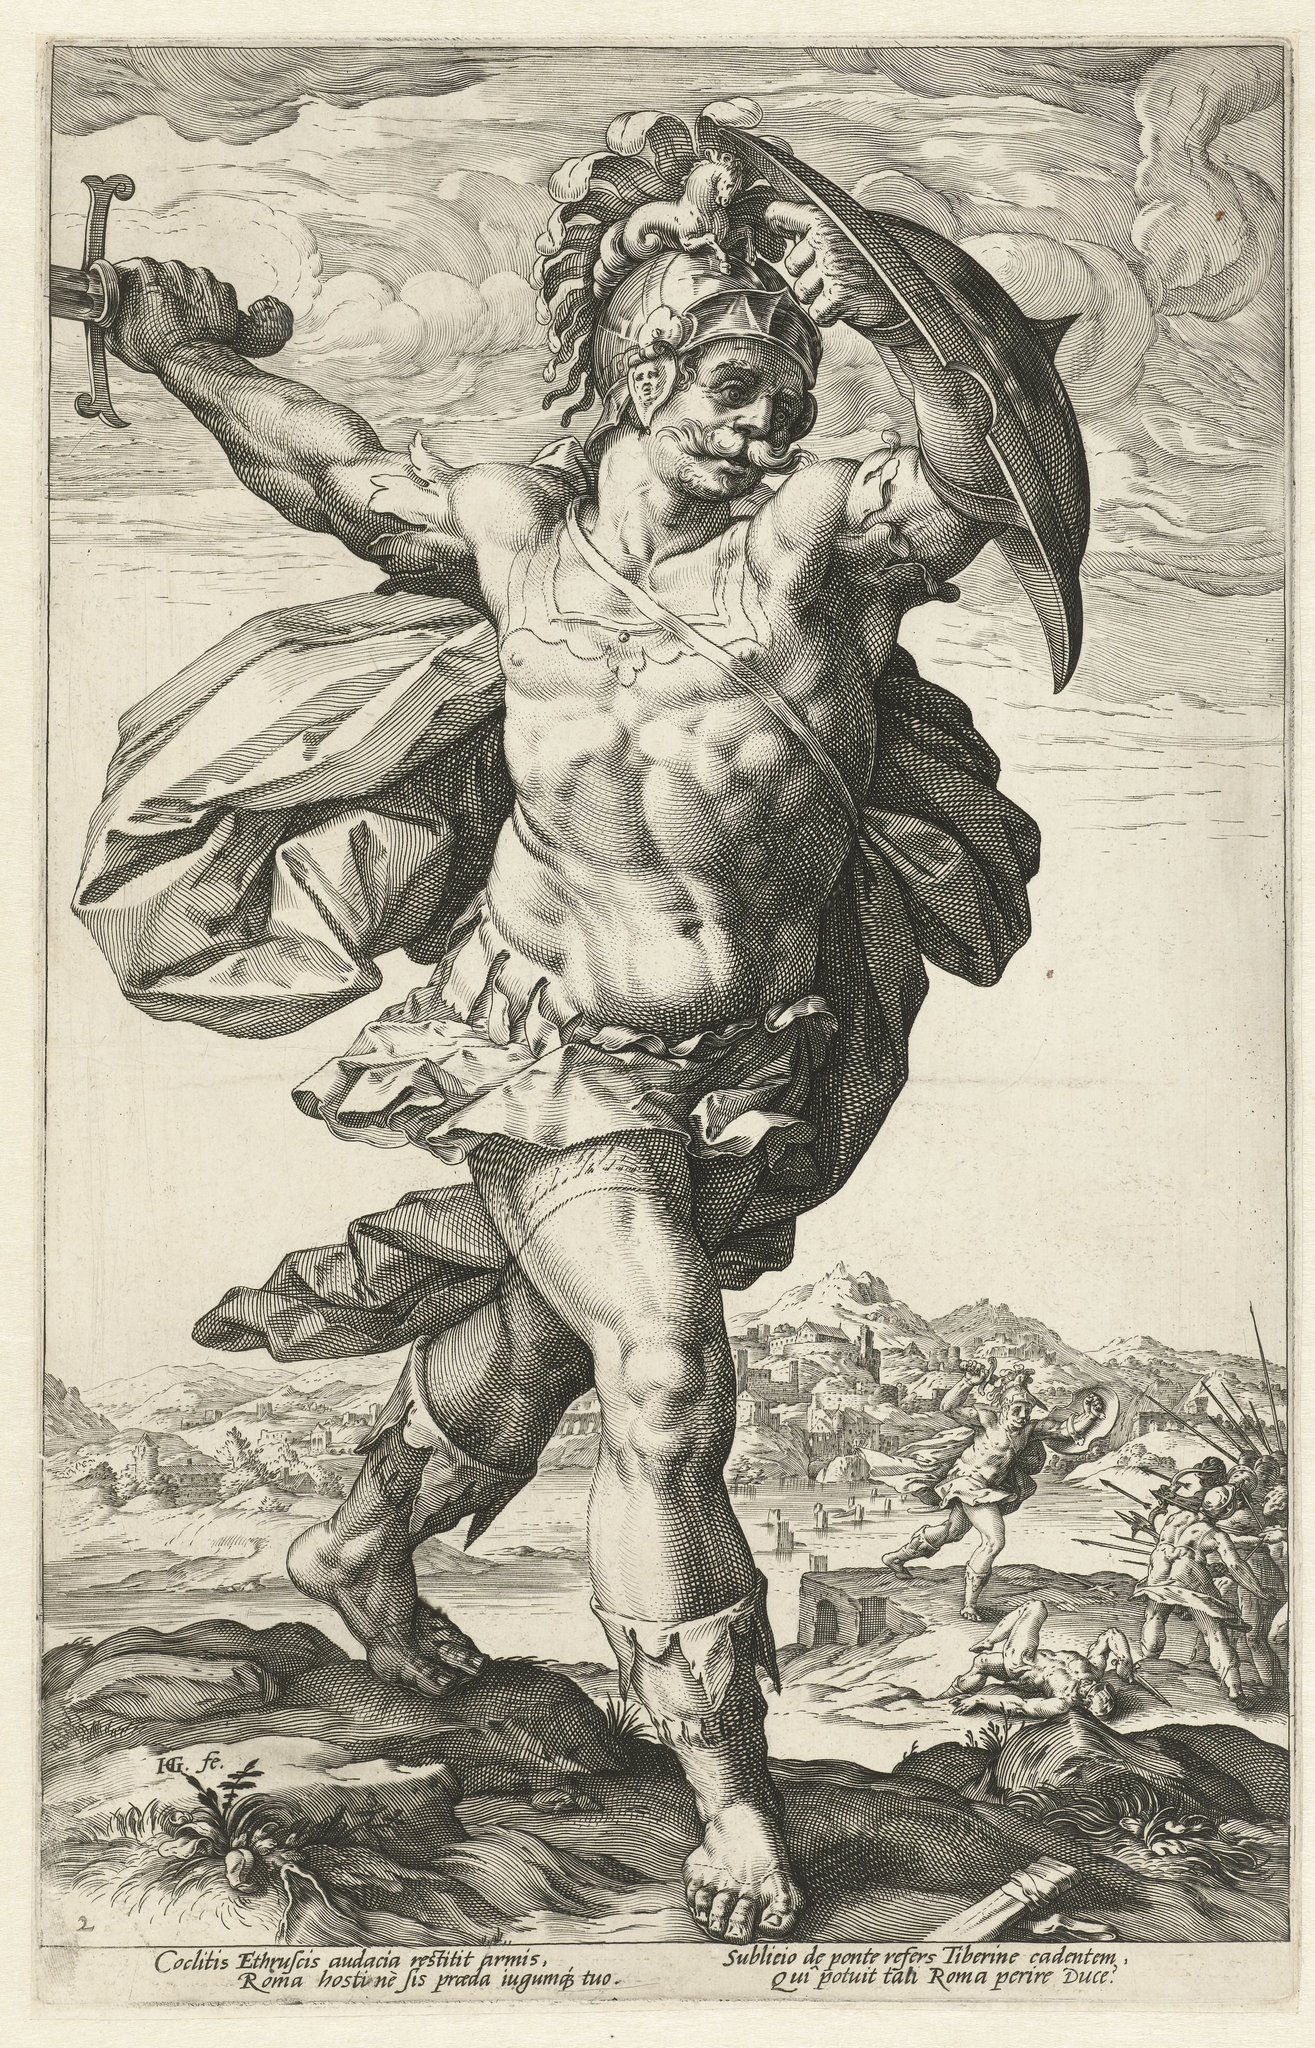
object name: print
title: Horatius Cocles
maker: hendrick goltzius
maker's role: draughtsman, painter, print maker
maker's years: 1558-1617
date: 1586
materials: paper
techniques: engraving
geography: haarlem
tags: horatius cocles at the pons sublicius: single-handed he keeps the etruscans at bay while the bridge is broken down by the romans behind him; he escapes by jumping into the tiber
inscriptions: collector's mark: Lugt 240, caption: ‘Coclitis Ethruscis...perire Duce’, signature: ‘HG. fe.’, number: ‘2’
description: De held Horatius Cocles ten voeten uit, een zwaard opgeheven in de rechterhand, een schild in de linkerhand. Op de achtergrond is te zien hoe hij het op de oever van de Tiber in zijn eentje opneemt tegen een heel leger. Onder de voorstelling twee maal twee versregels in Latijn. Deze prent is onderdeel van een serie van tien prenten, bestaand uit een ongenummerde titelprent, acht genummerde voorstellingen van helden en een ongenummerde afsluitende prent.